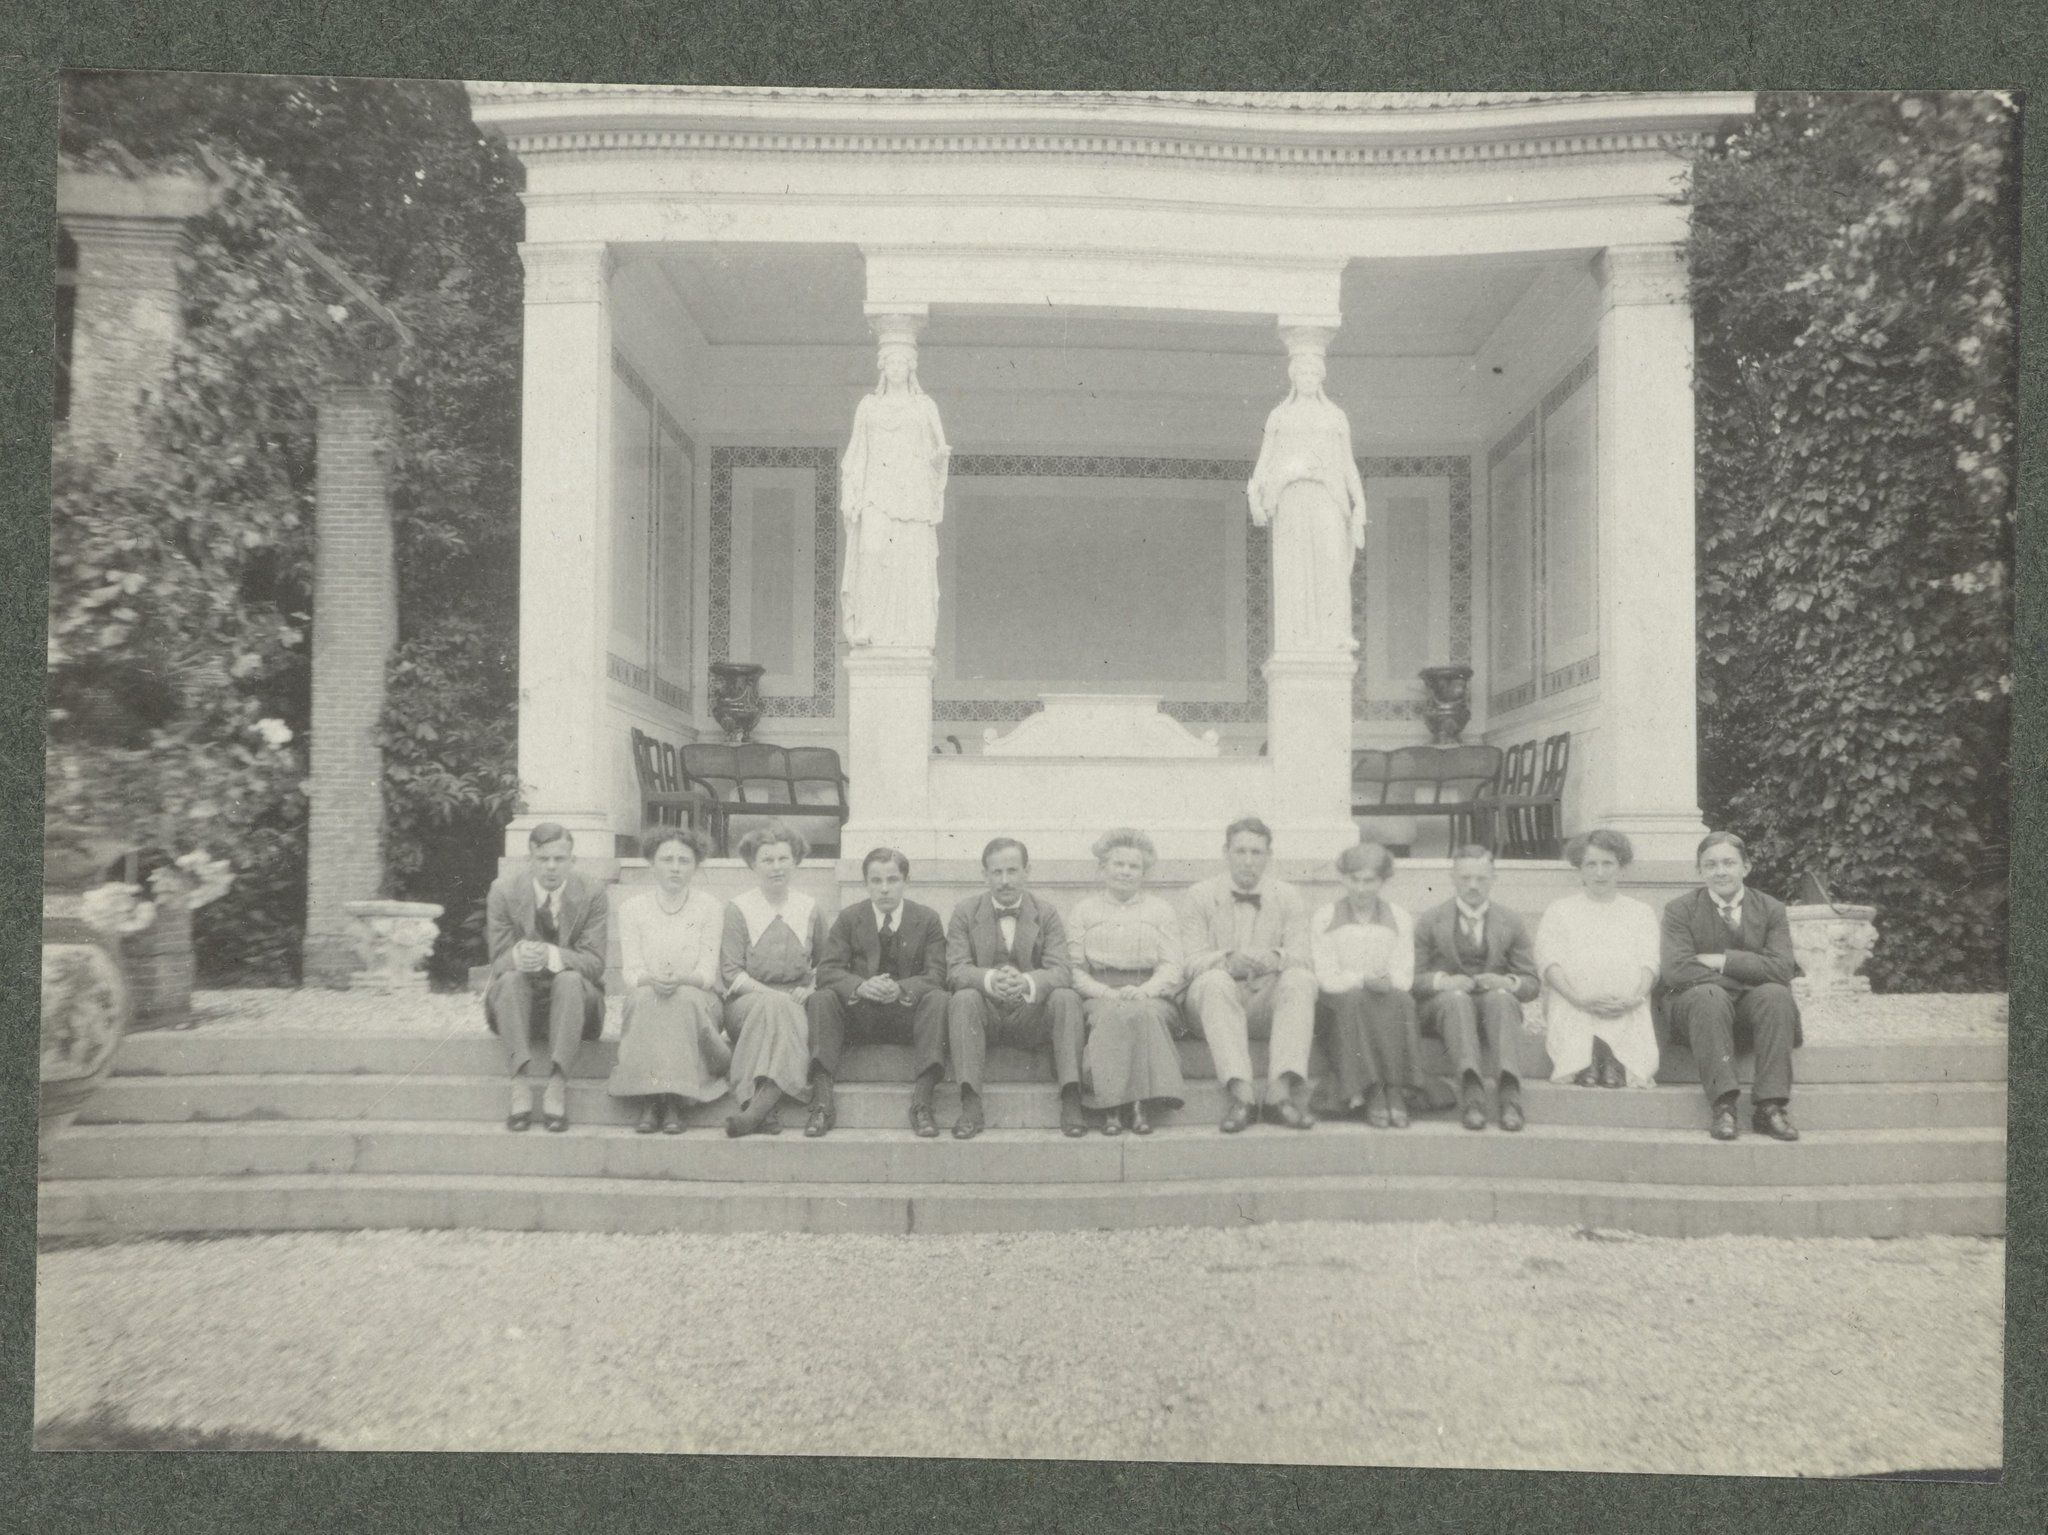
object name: photograph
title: Familie Kessler op de trap van het buitenhuis in de tuin van landgoed Pauw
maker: geldolph adriaan kessler (dolph)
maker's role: fotograaf, industrieel, voetballer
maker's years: 1884-1945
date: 1913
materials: paper, photographic support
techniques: photography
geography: netherlands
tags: huize de paauw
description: In het midden zit mevrouw Kessler de Lange. Tweede van rechts is Digna Fransen van de Putte.